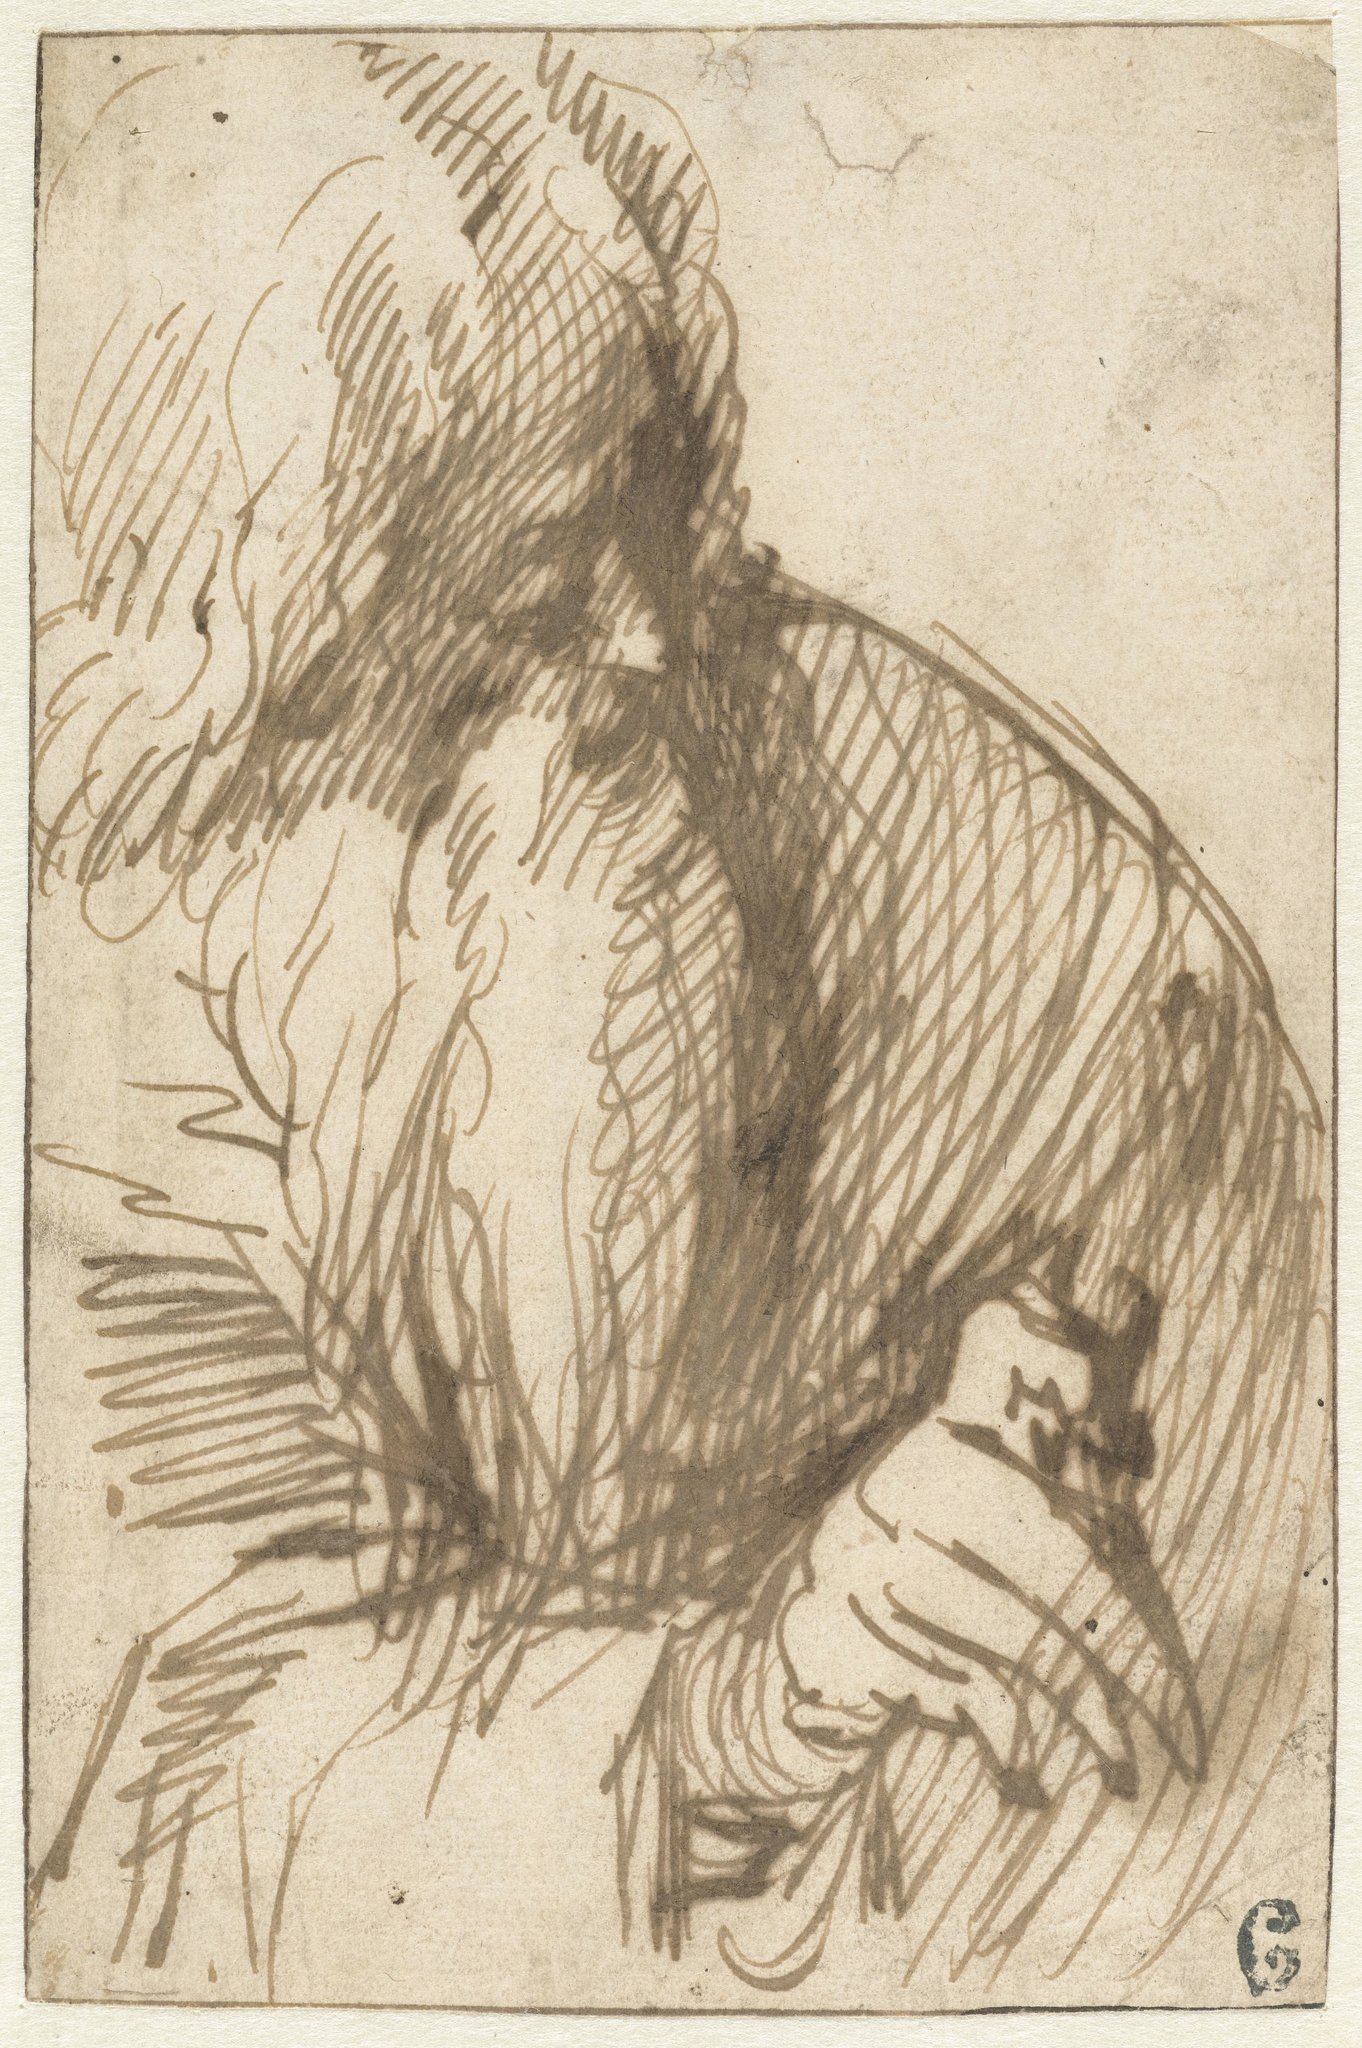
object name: drawing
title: Grijsaard met half opgeheven hand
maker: hendrick goudt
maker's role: draughtsman, print maker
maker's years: 1581-1648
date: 1580-1648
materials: ink, paper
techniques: pen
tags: arm raised, with fingers spread out